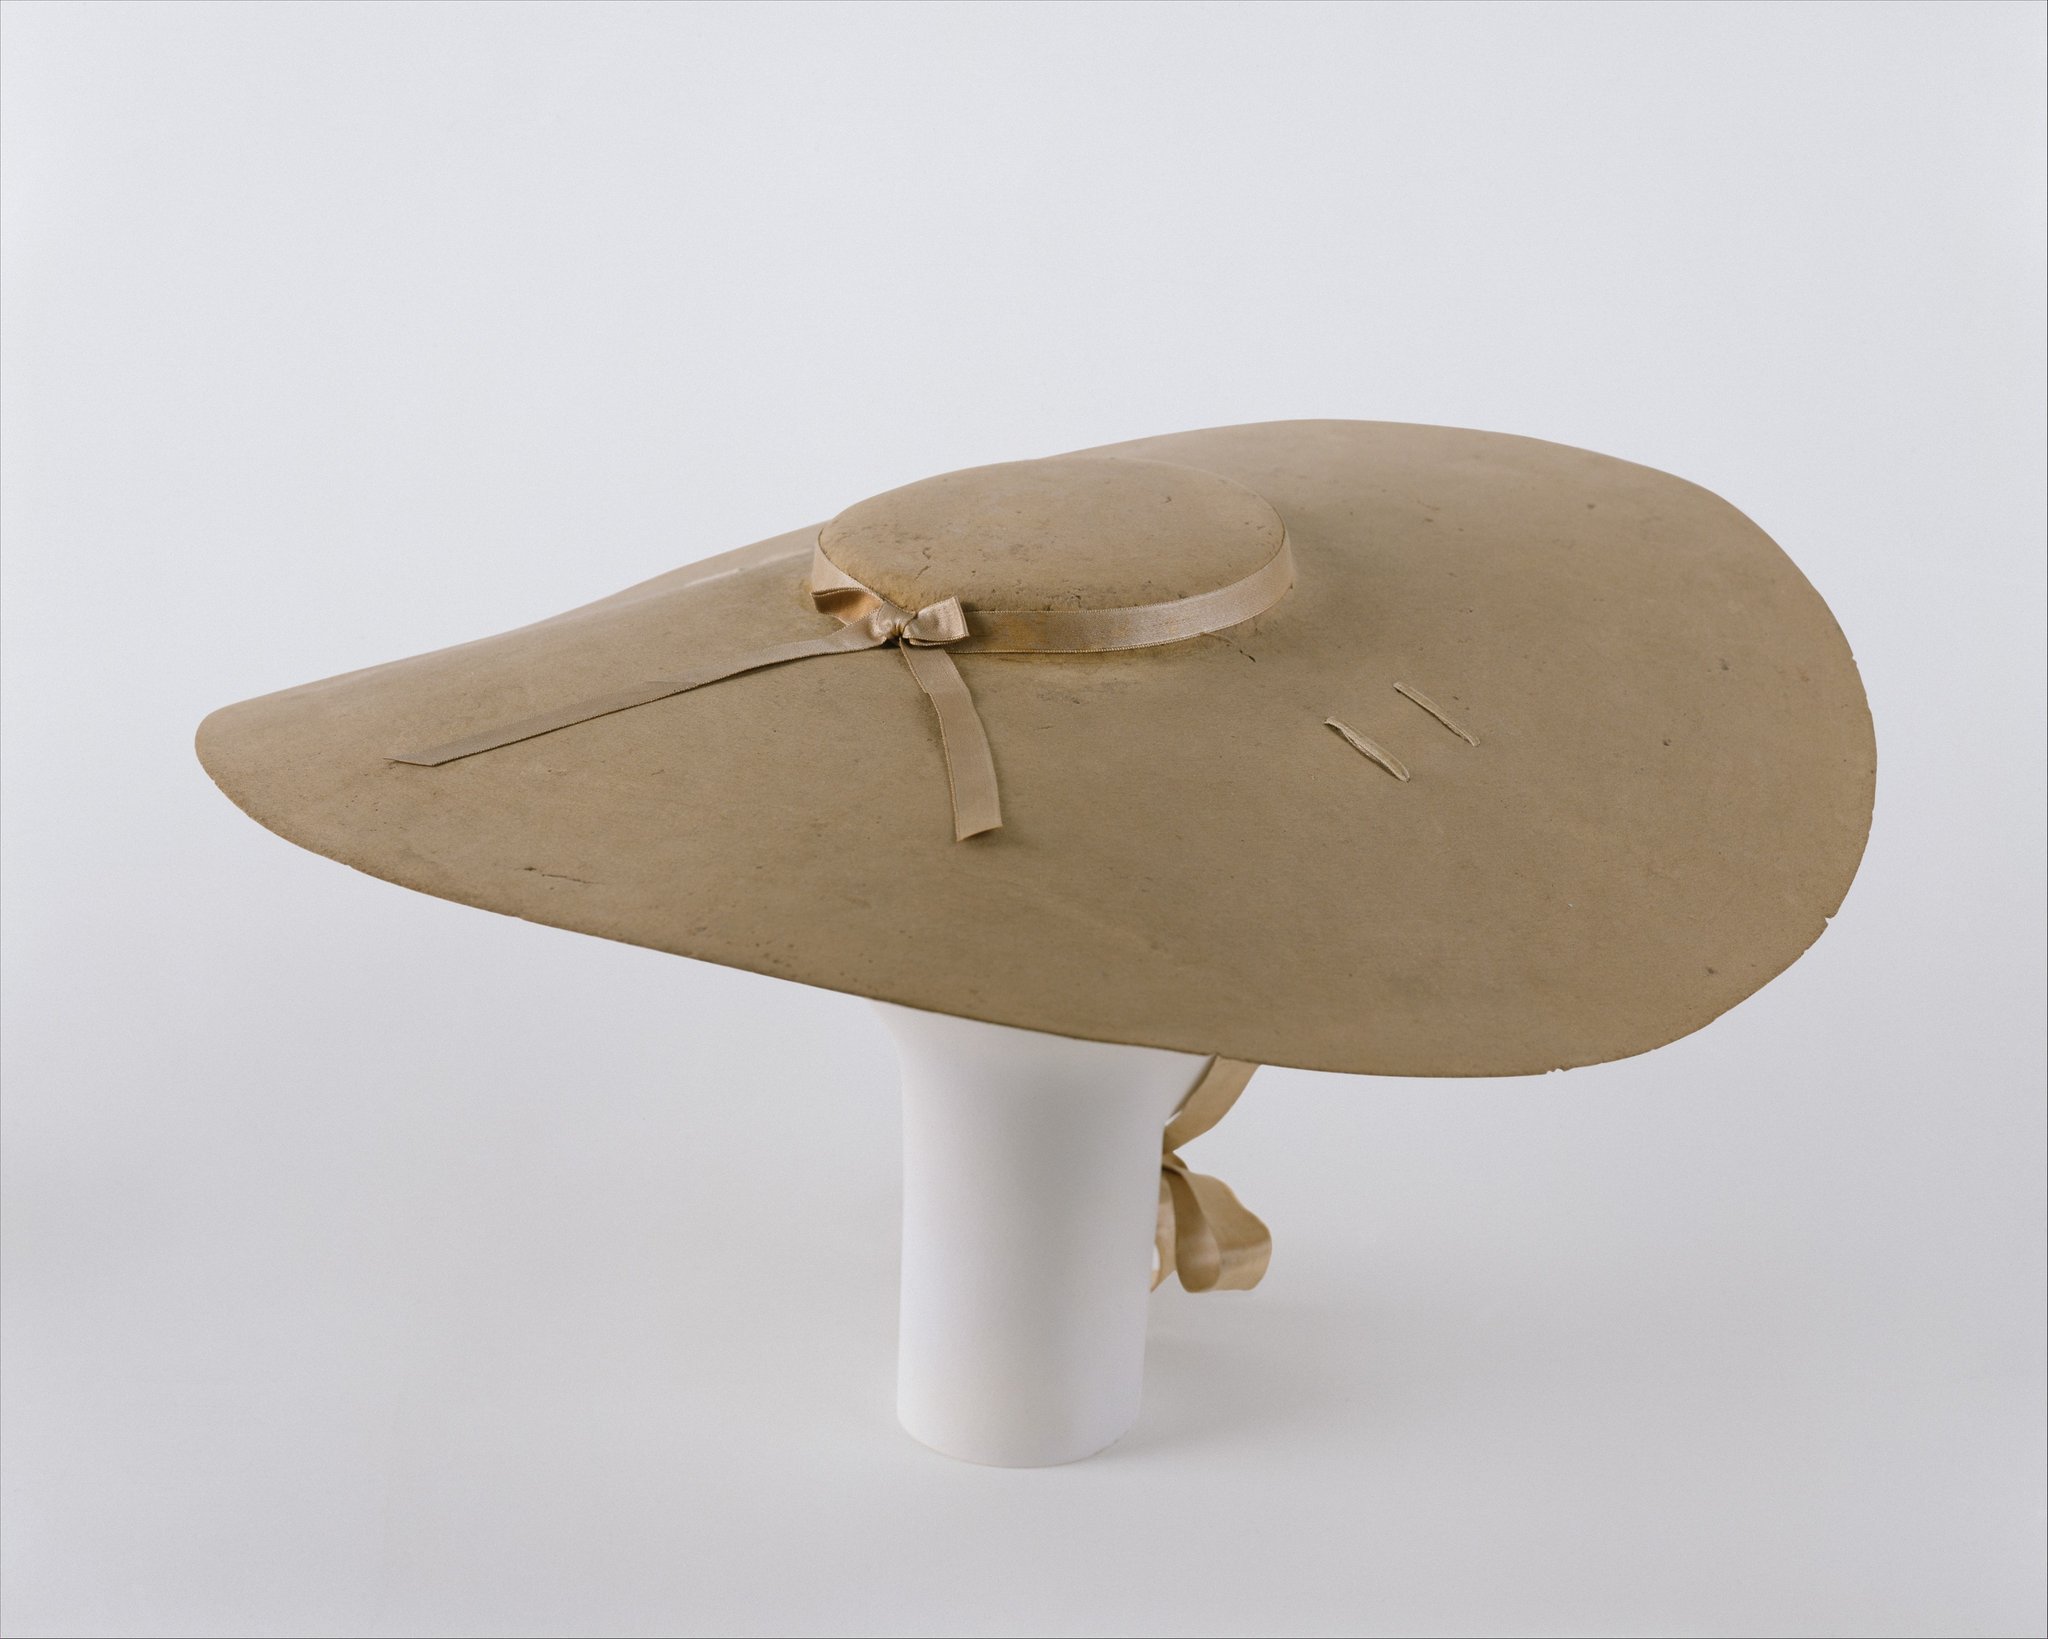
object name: hat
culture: german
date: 1720-1750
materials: silk, wool